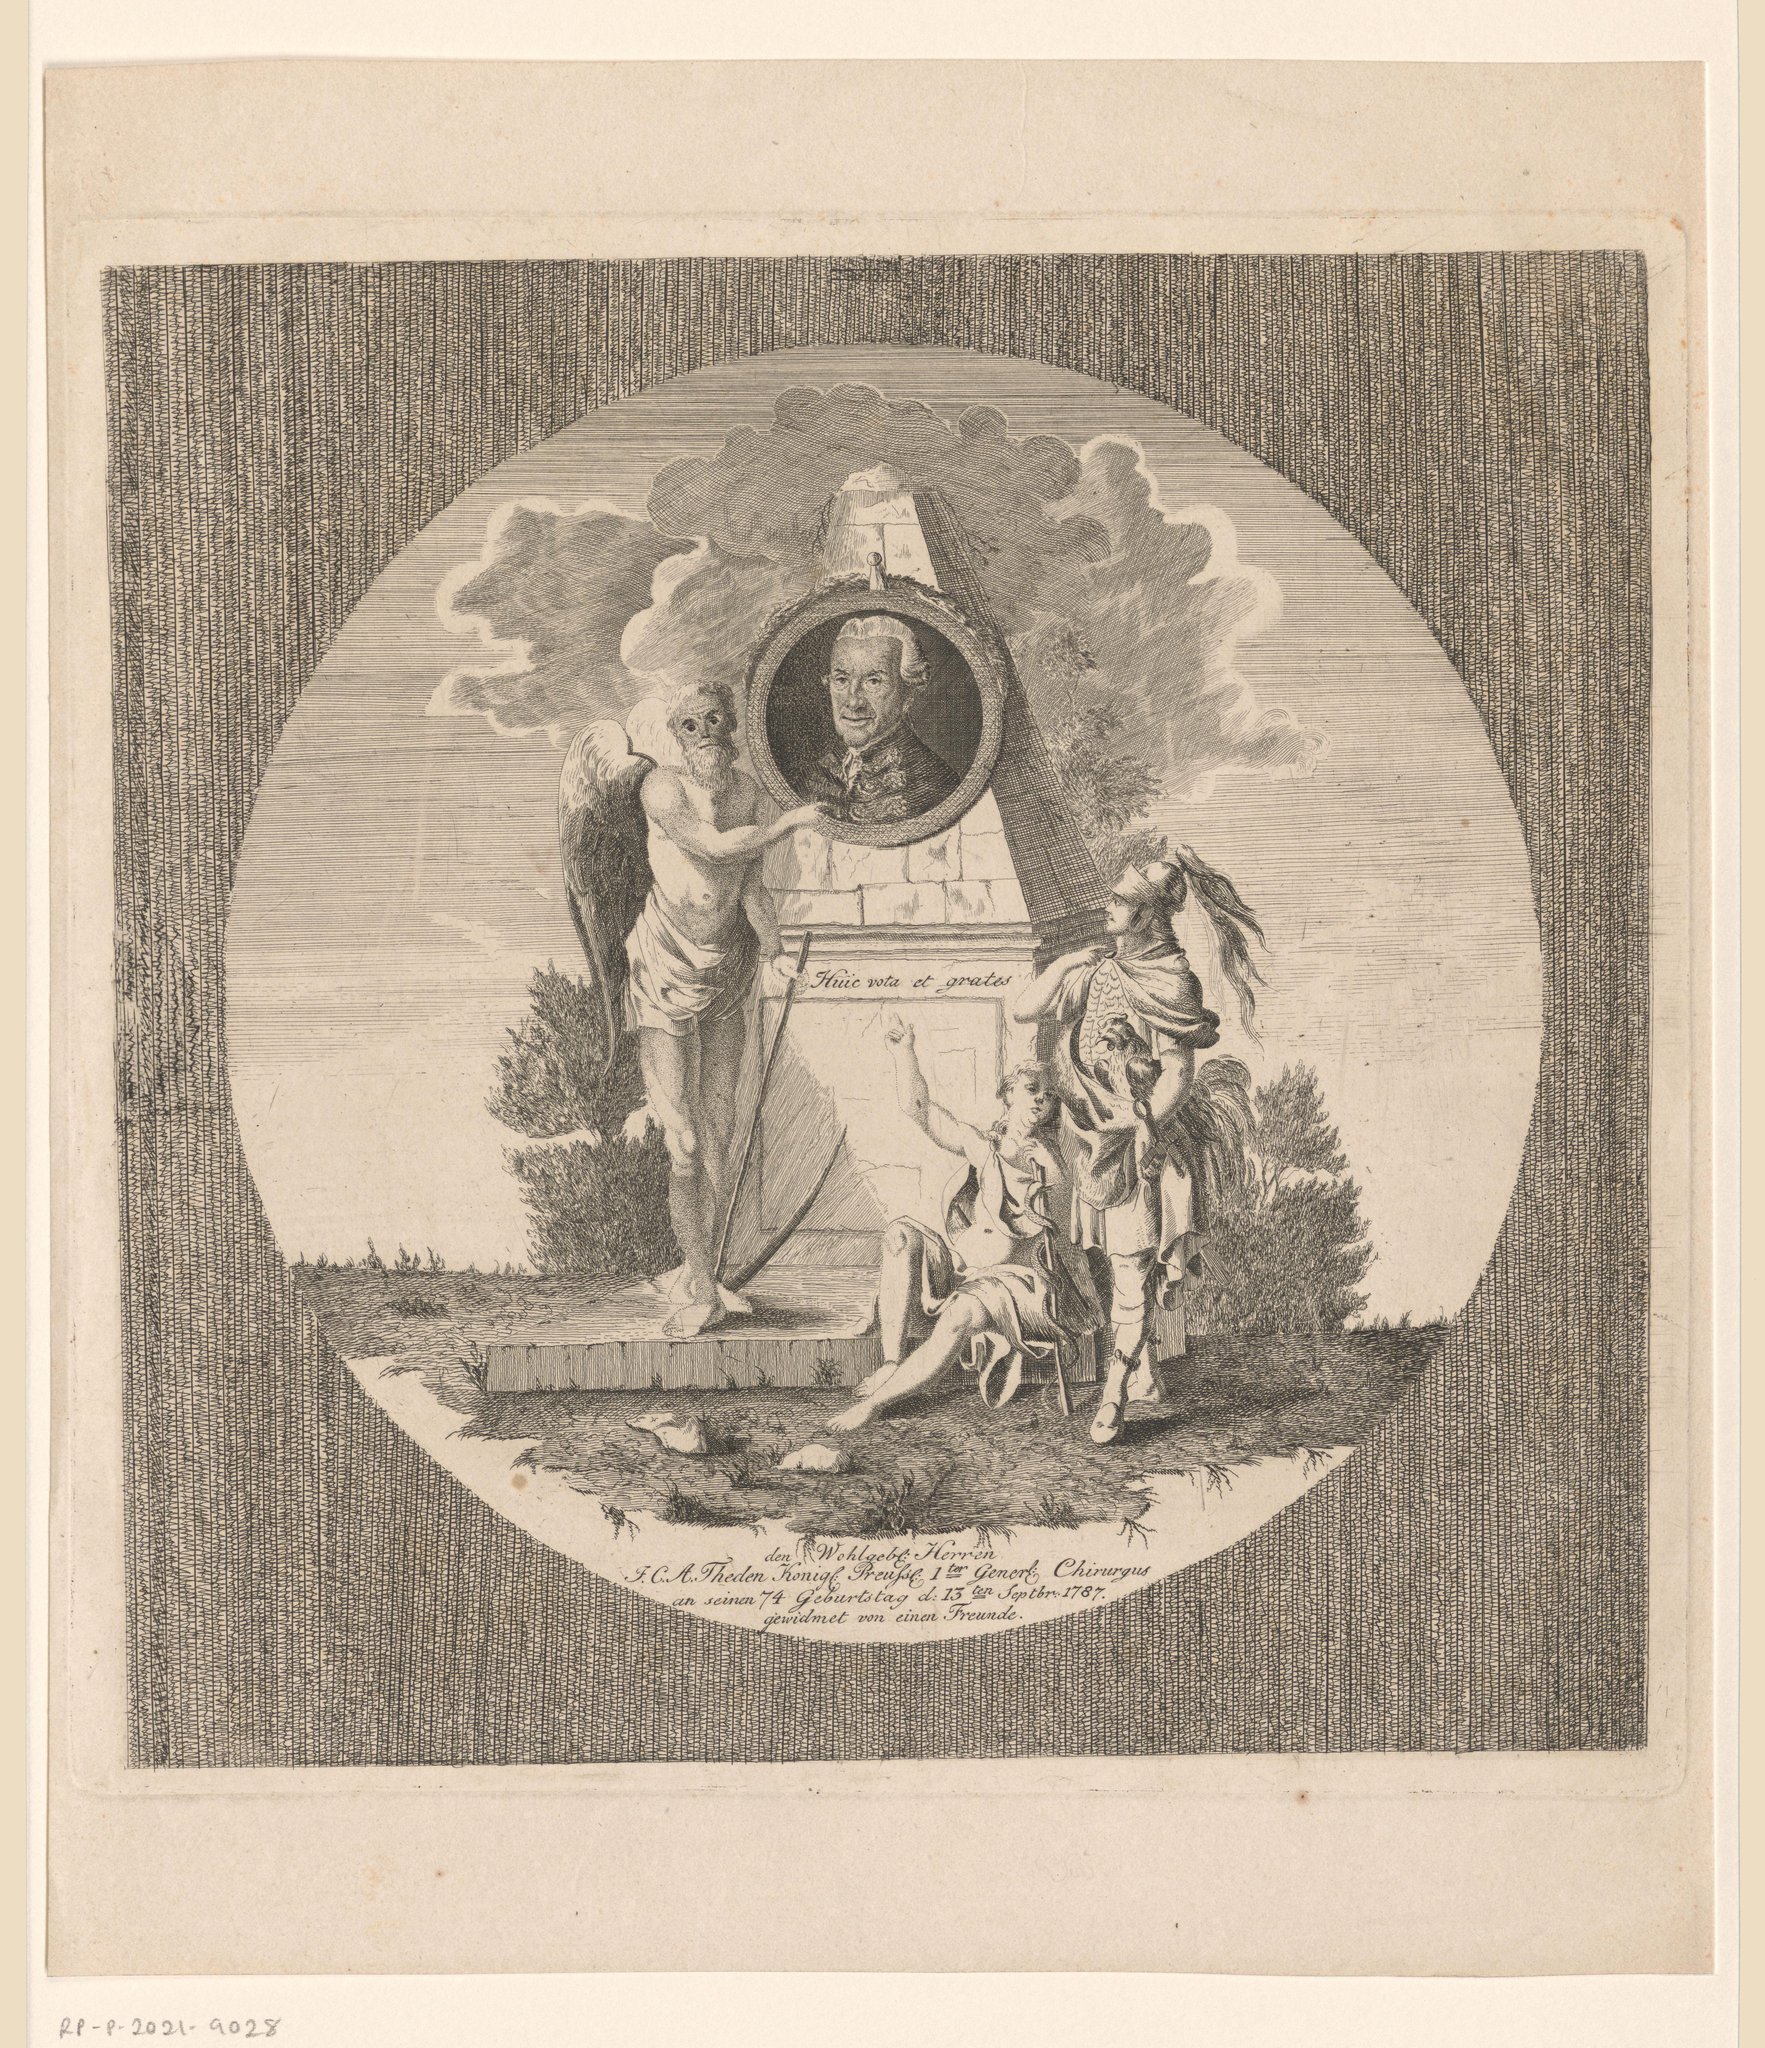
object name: print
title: Monument ter ere van Johann Christian Anton Theden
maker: Anonymous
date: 1787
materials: paper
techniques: etching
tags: historical persons, physician, doctor, monument, statue, fowl (cock, hen, chicken, etc.), (story of) aesculapius (asclepius), father time, man with wings and scythe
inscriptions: date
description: Met links van het monument Tijd en rechts Asclepius en een man met een haan, mogelijk Mercurius.